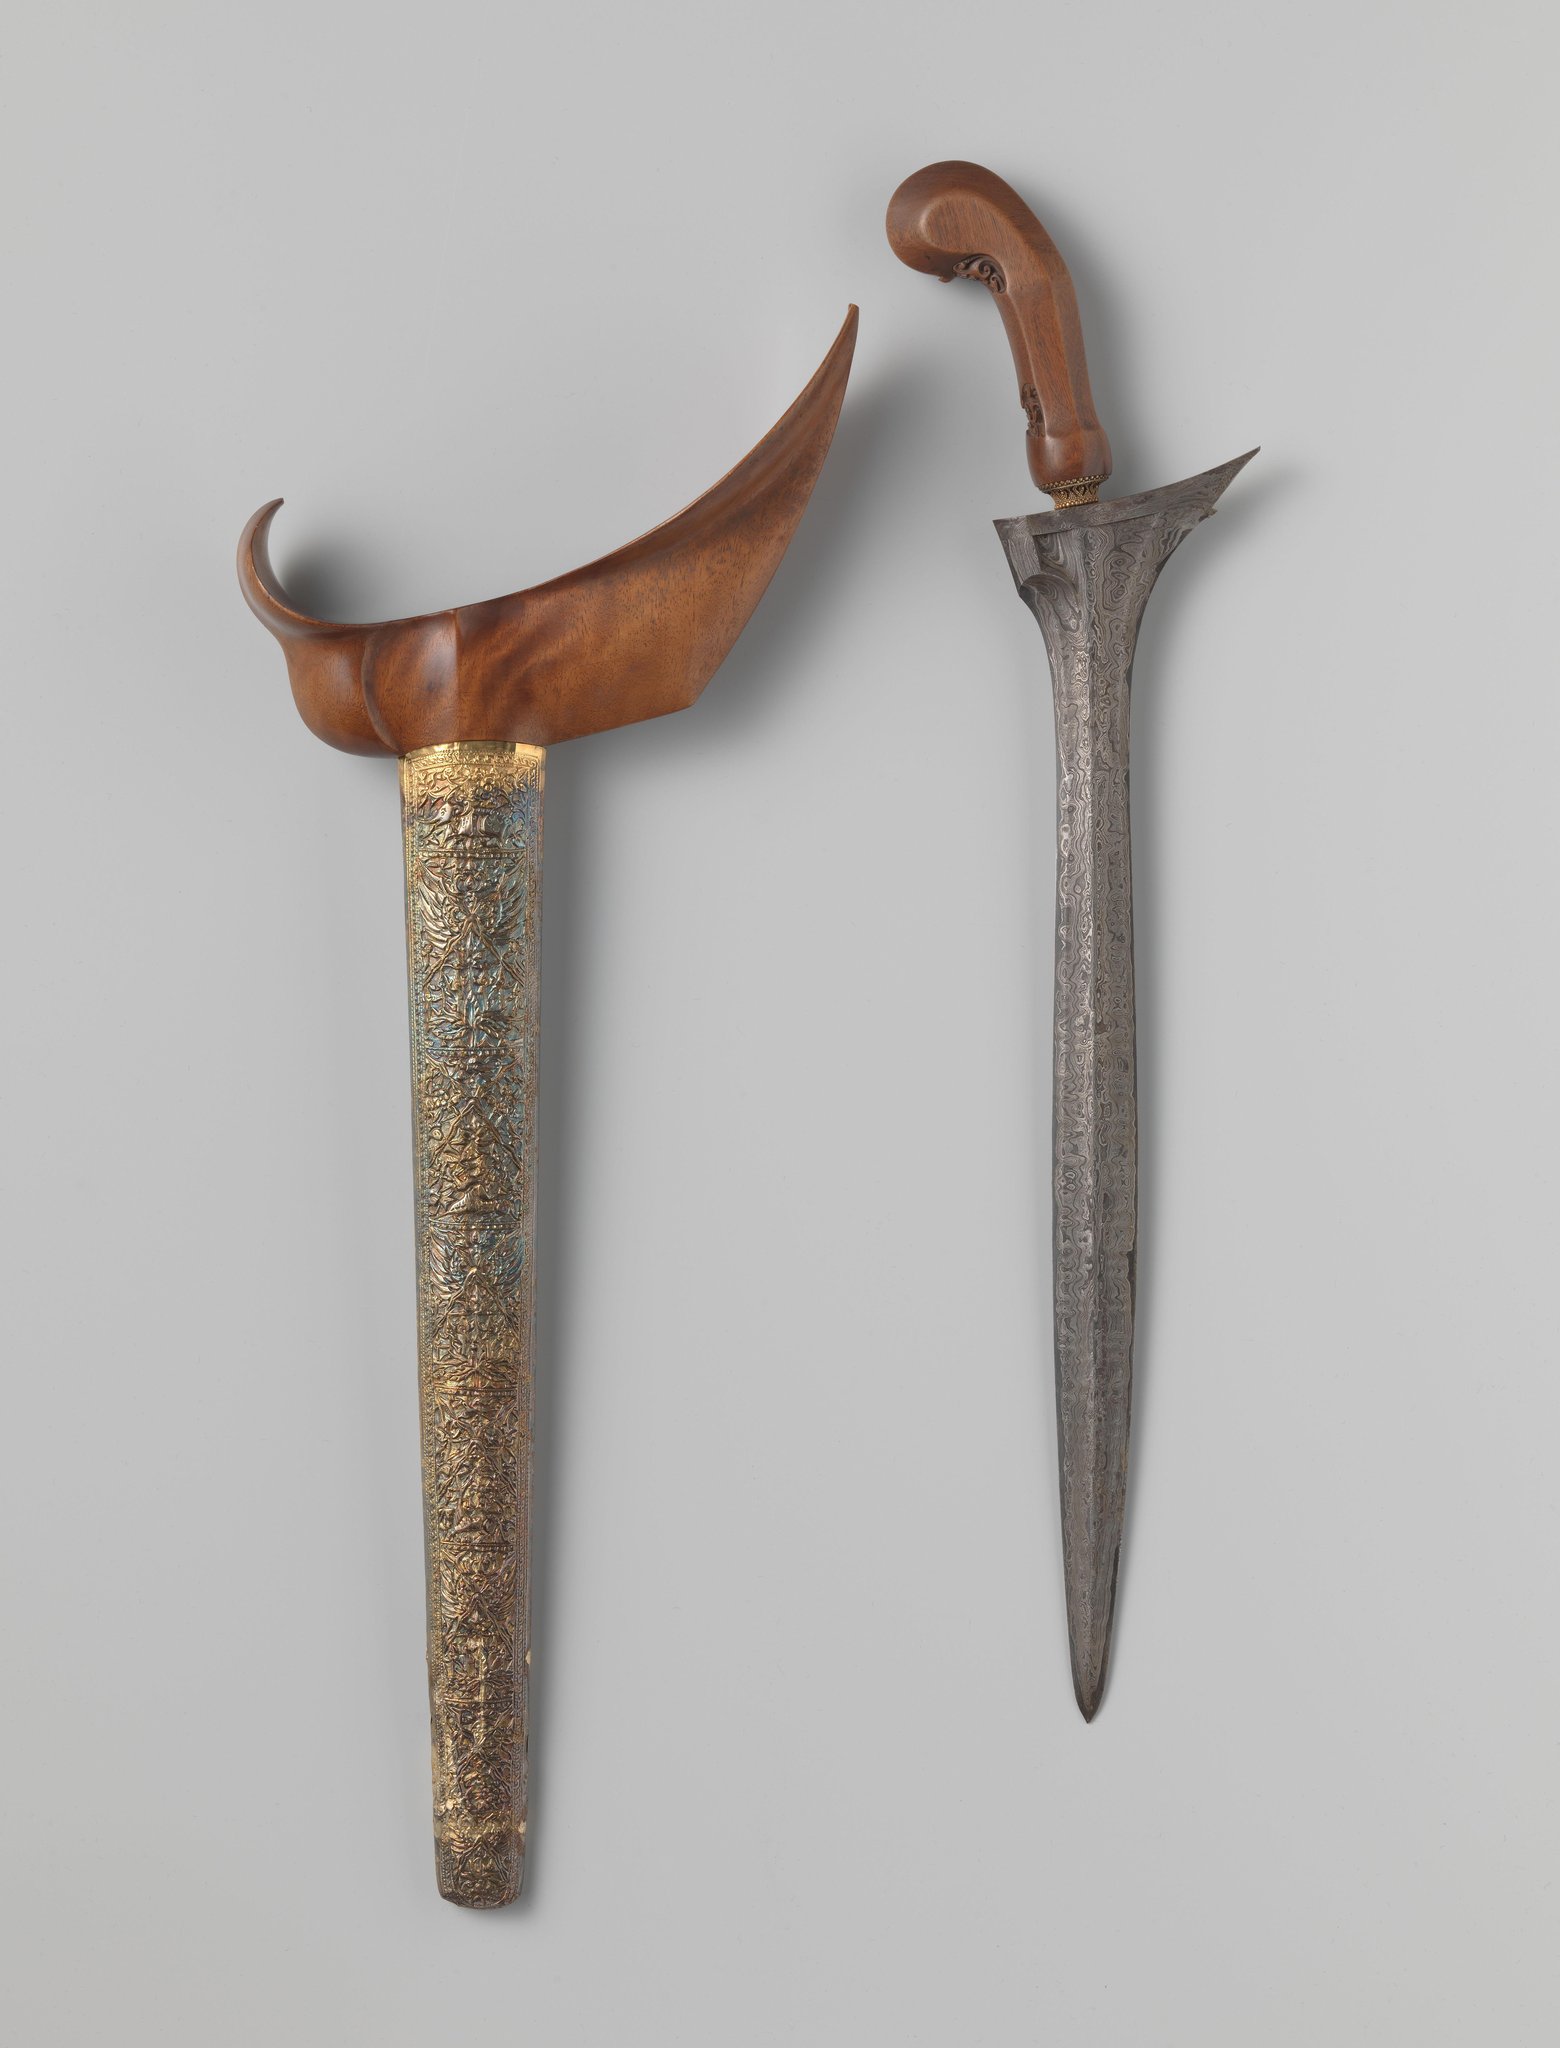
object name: kris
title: Javaanse kris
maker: Anonymous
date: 1500-1900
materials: iron, nickel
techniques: pamo technique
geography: java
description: Kris, waarvan het lemmet versierd in pamor-techniek.